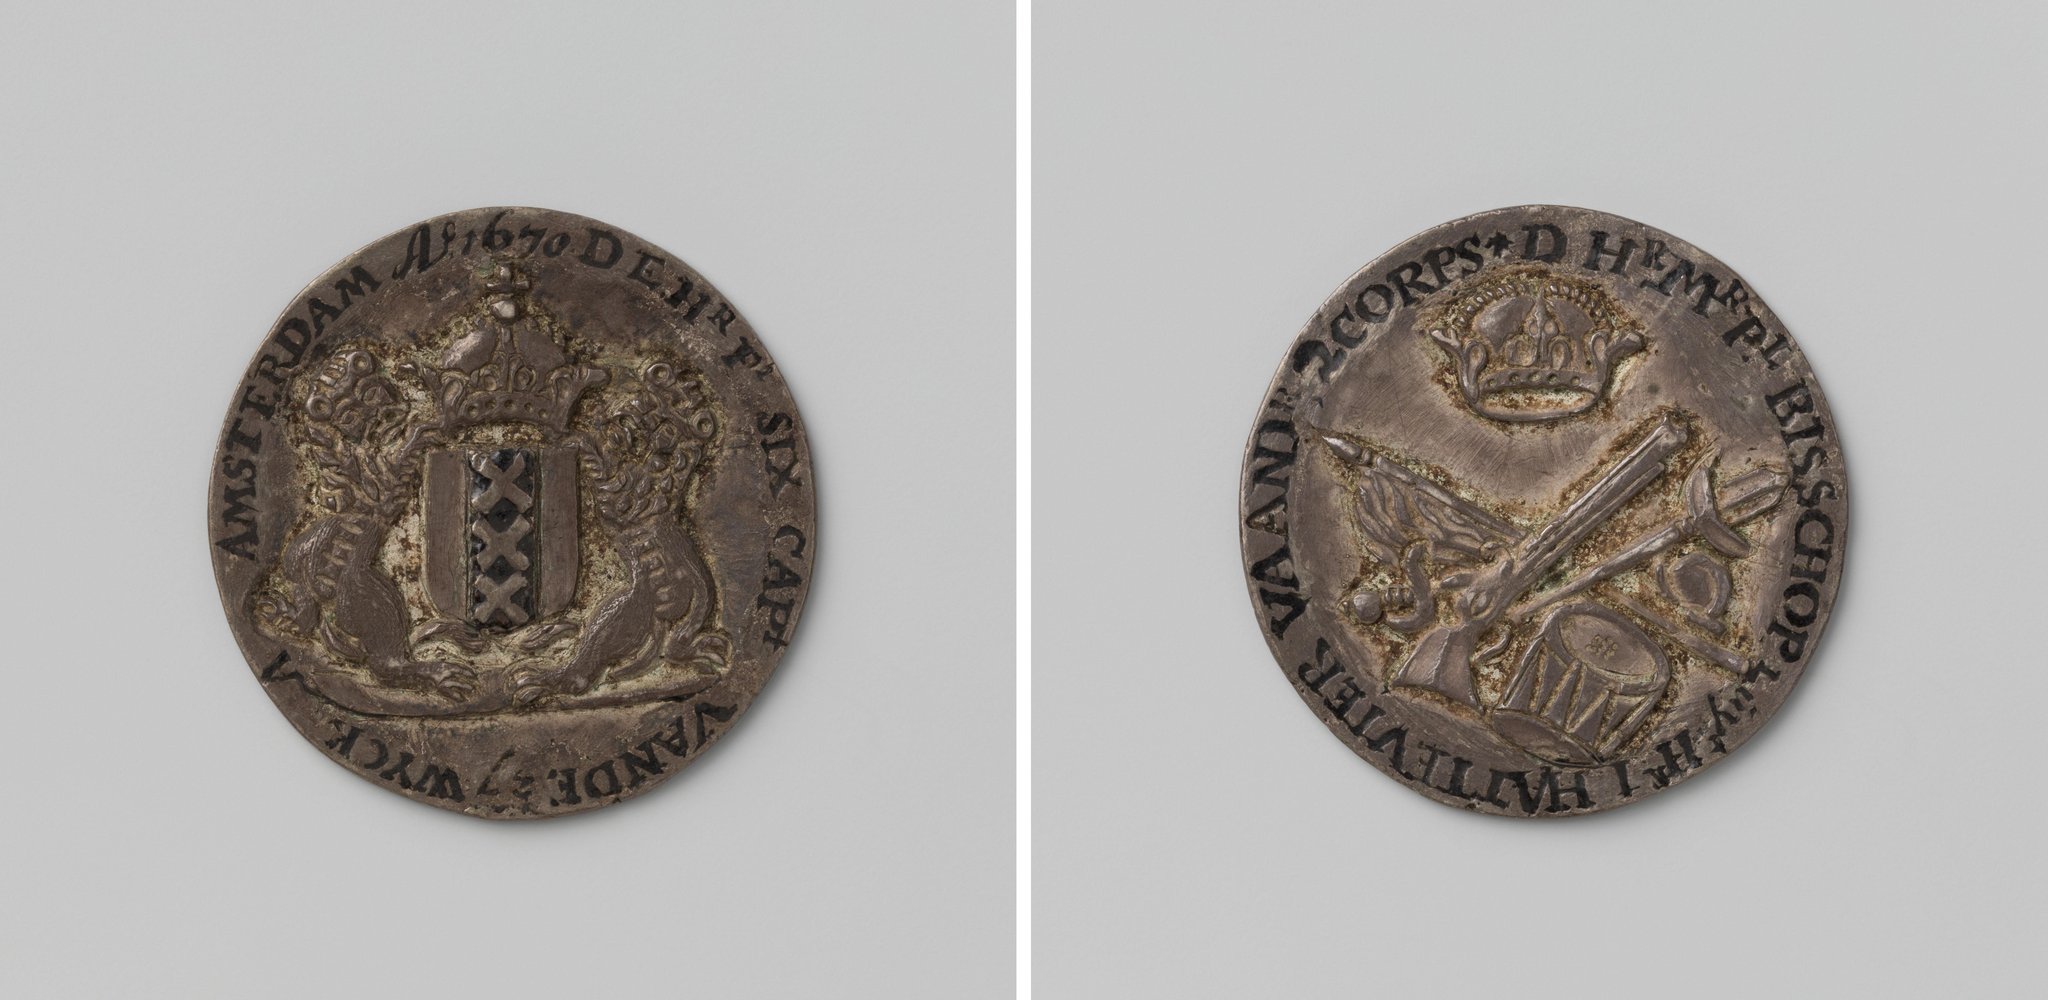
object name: marksman medal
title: Schutterij van wijk 27 te Amsterdam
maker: Anonymous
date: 1670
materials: silver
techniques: casting, colour, engraving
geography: amsterdam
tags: amsterdam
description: Zilveren penning. Voorzijde: gekroond wapenschild, geflankeerd door twee leeuwen binnen omschrift. Keerzijde: vaandel, piek, zwaard, geweer, helm en trom onder kroon binnen omschrift.